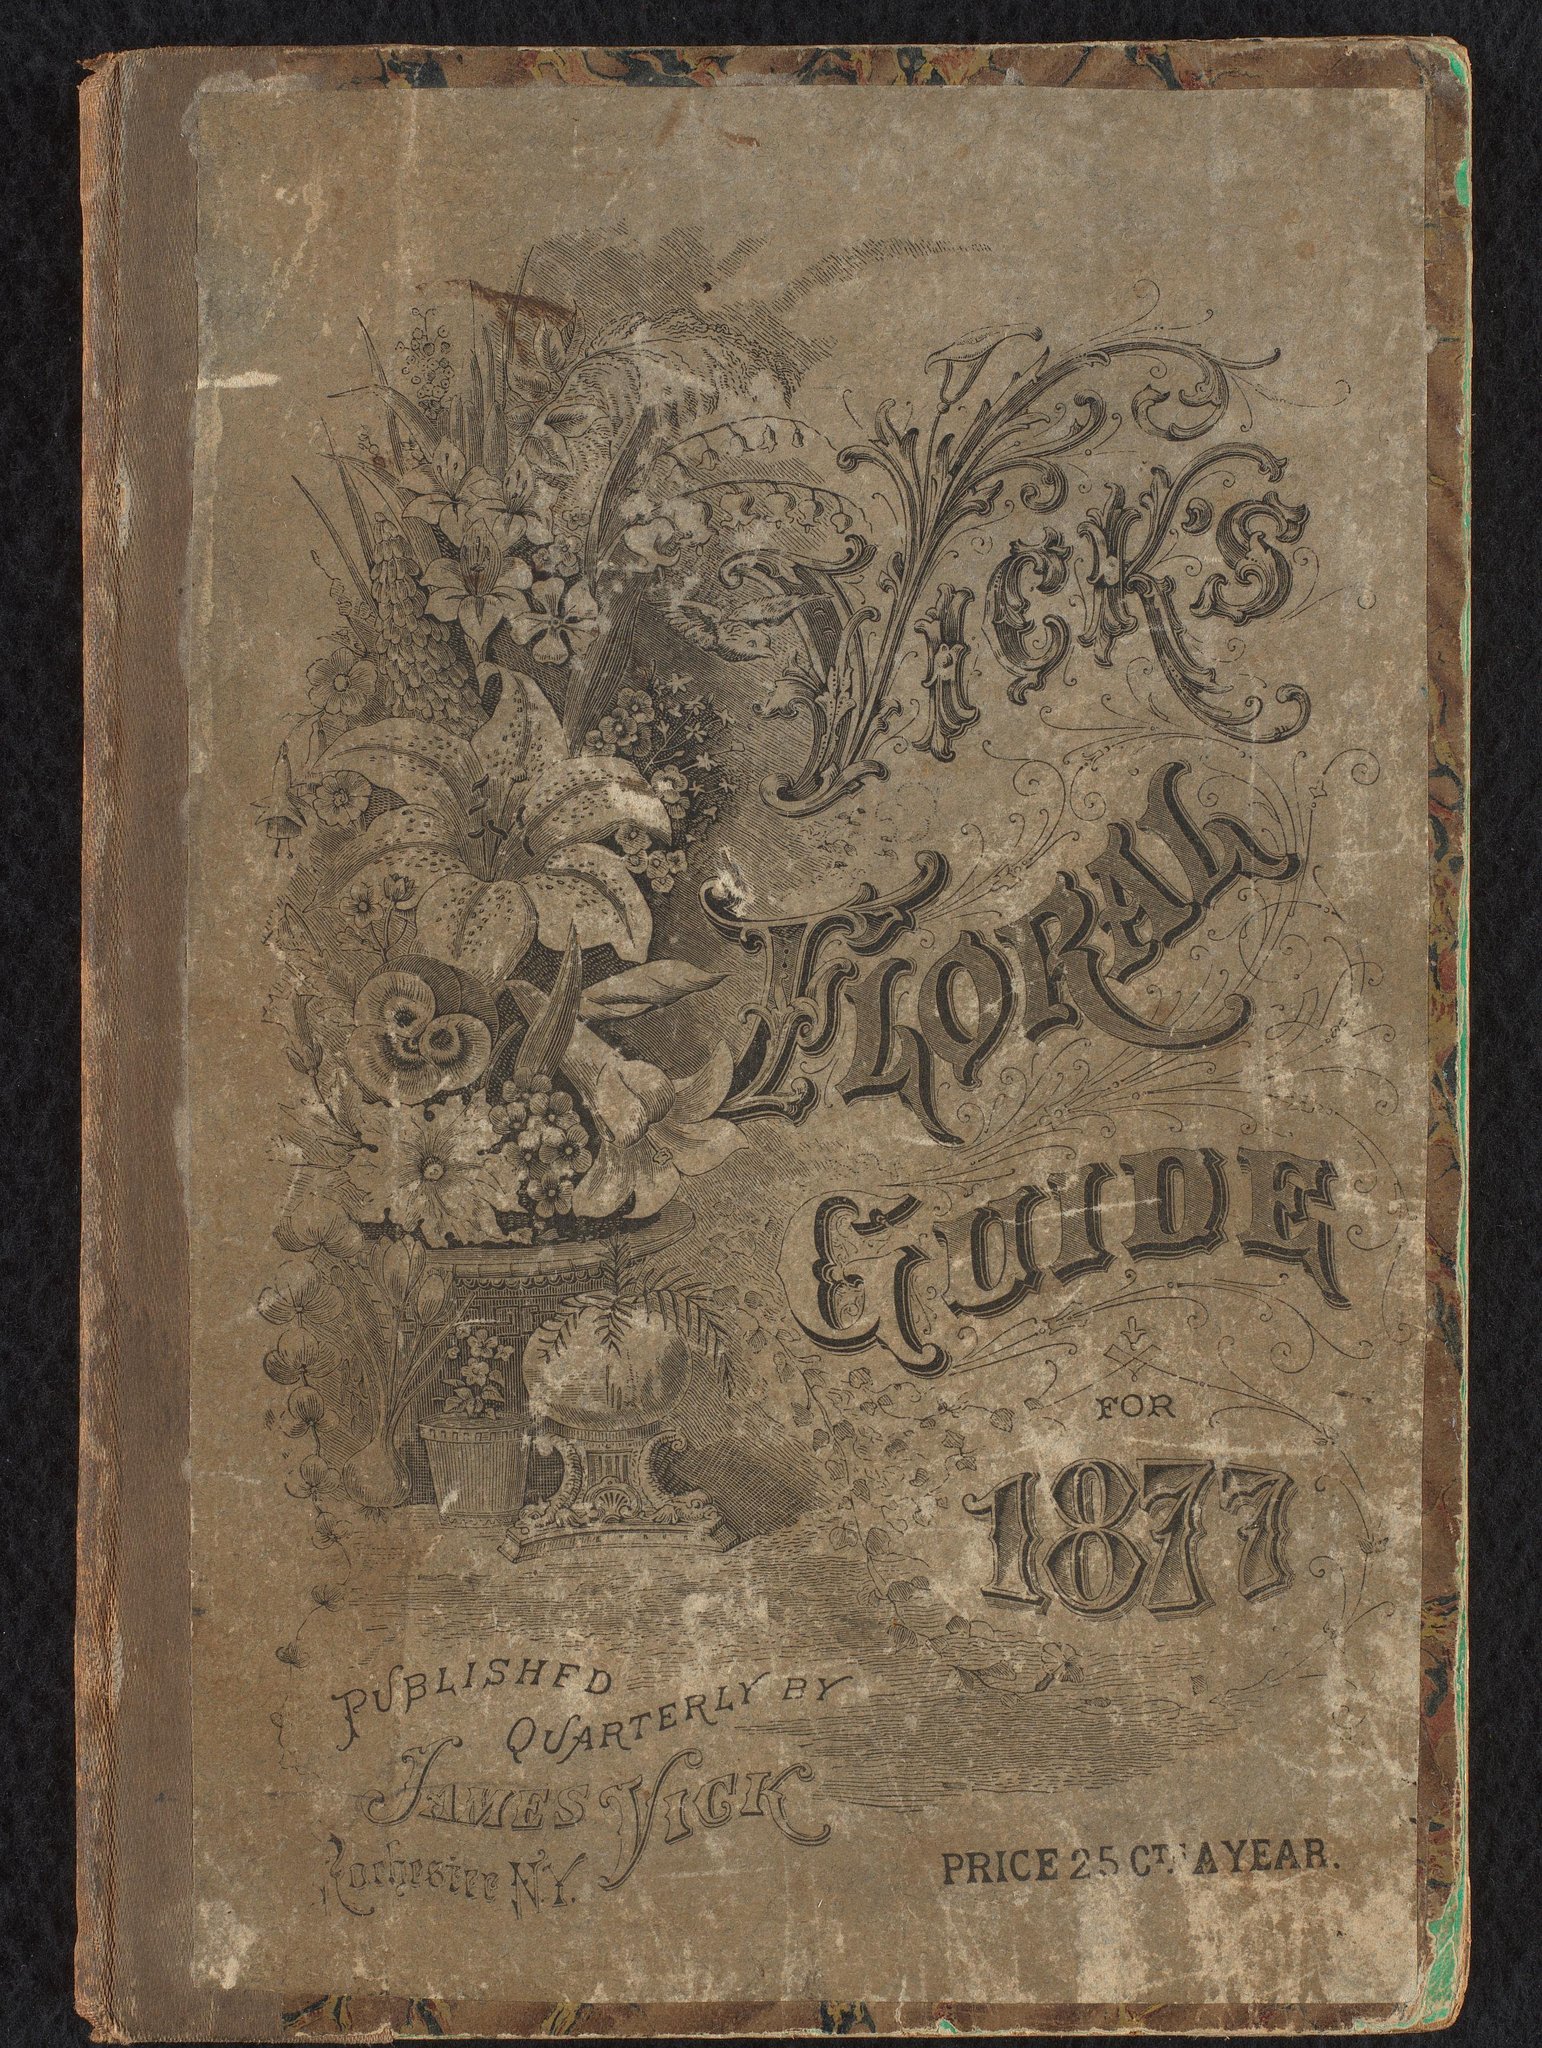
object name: book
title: Vick's floral guide for 1877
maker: james vick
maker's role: publisher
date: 1877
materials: cardboard, paper, textile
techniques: albumen print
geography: rochester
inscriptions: date: ‘SEPT/ 2003’, inscription: ‘$195/ F/ 374/ E/ 19’